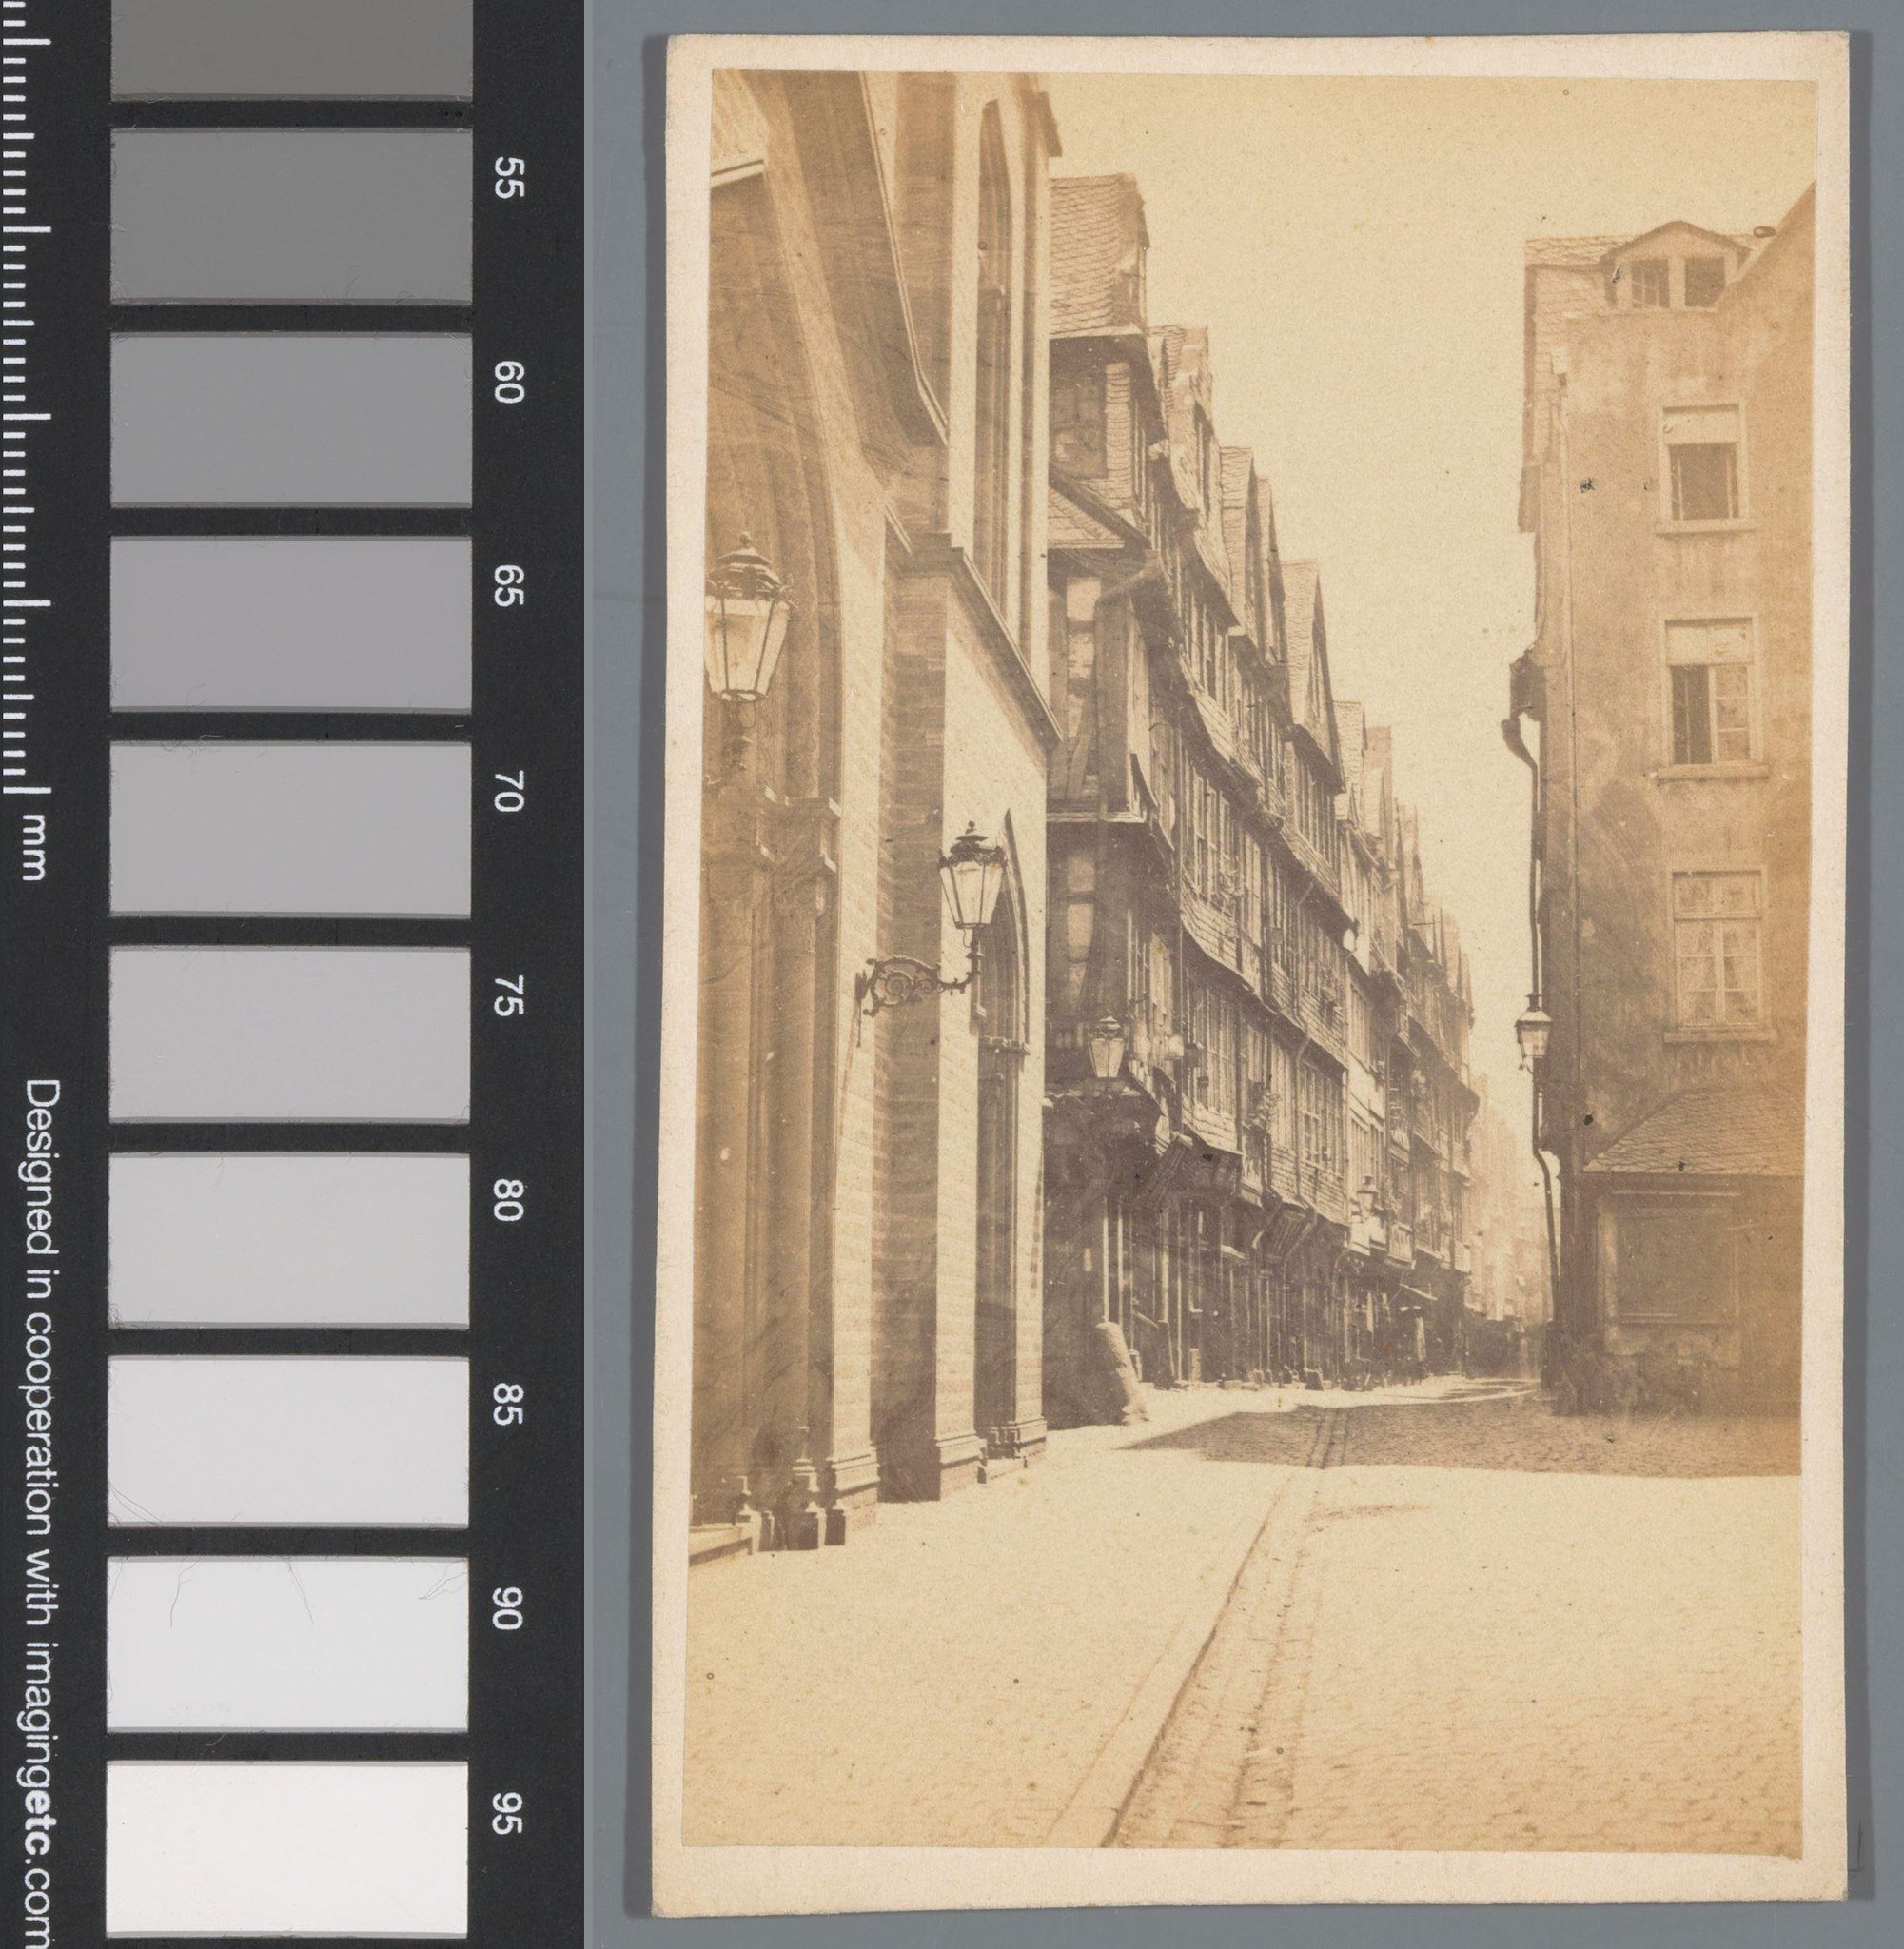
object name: carte de visite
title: Judengasse, Ffurt a/Main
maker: Anonymous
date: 1860-1875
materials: cardboard, paper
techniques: albumen print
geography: frankfurt am main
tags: passage